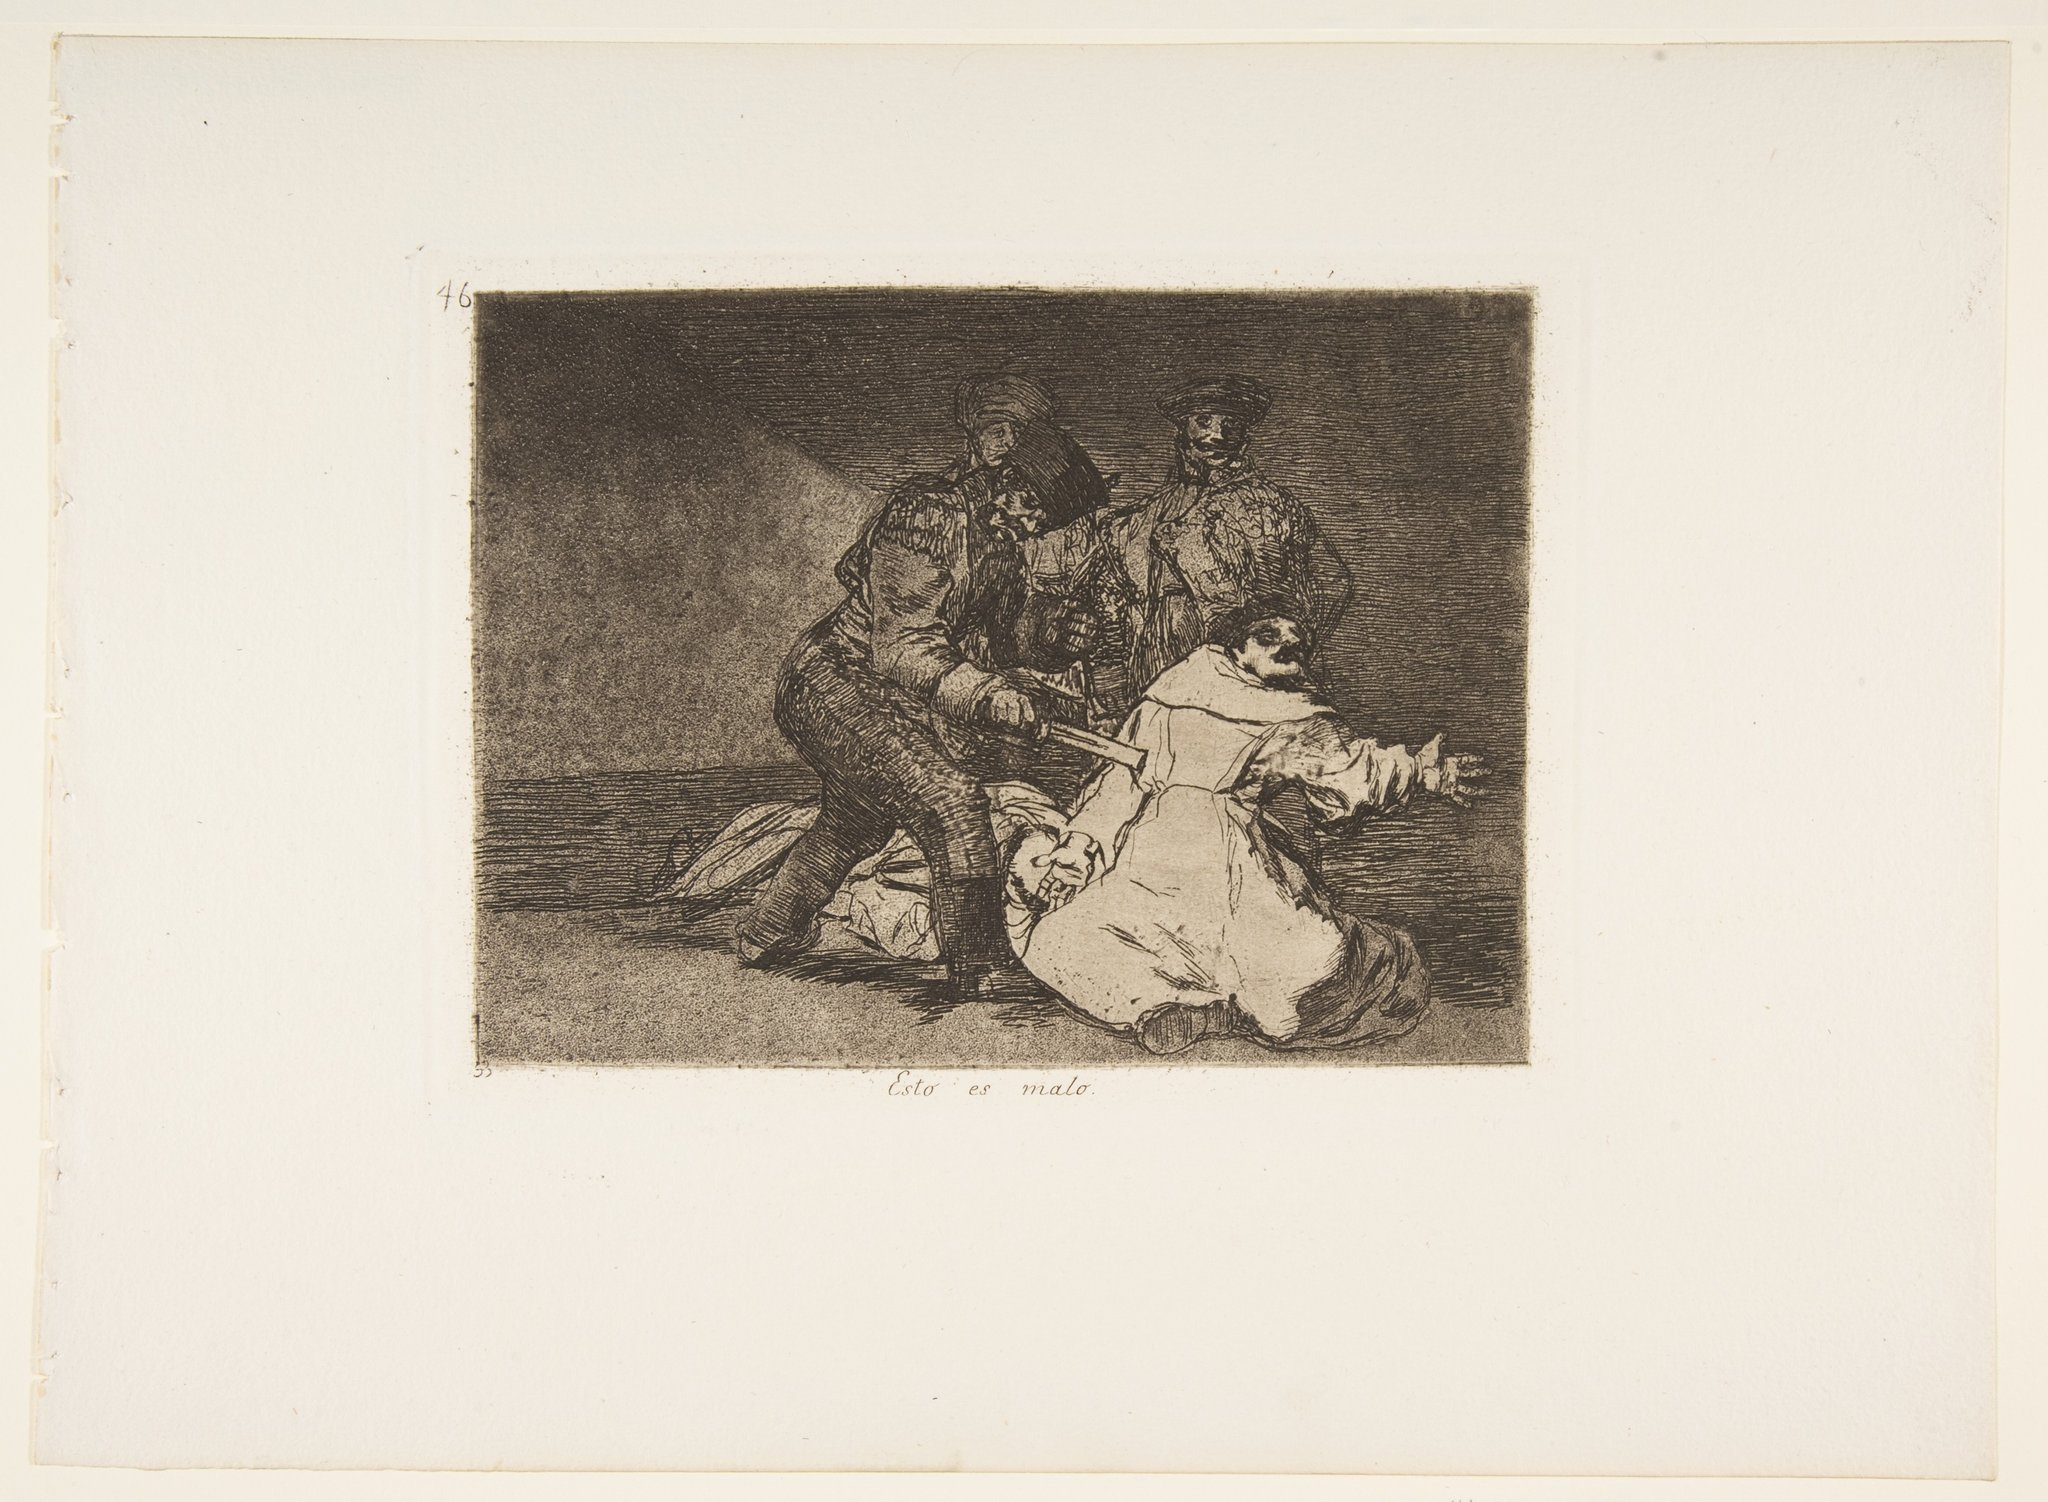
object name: print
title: Plate 46 from "The Disasters of War" (Los Desastres de la Guerra): 'This is bad' (Esto es malo)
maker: goya (francisco de goya y lucientes)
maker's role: artist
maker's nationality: spanish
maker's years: 1746-1828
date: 1810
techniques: aquatint, engraving, burnishing, drypoint, etching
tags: suffering,men